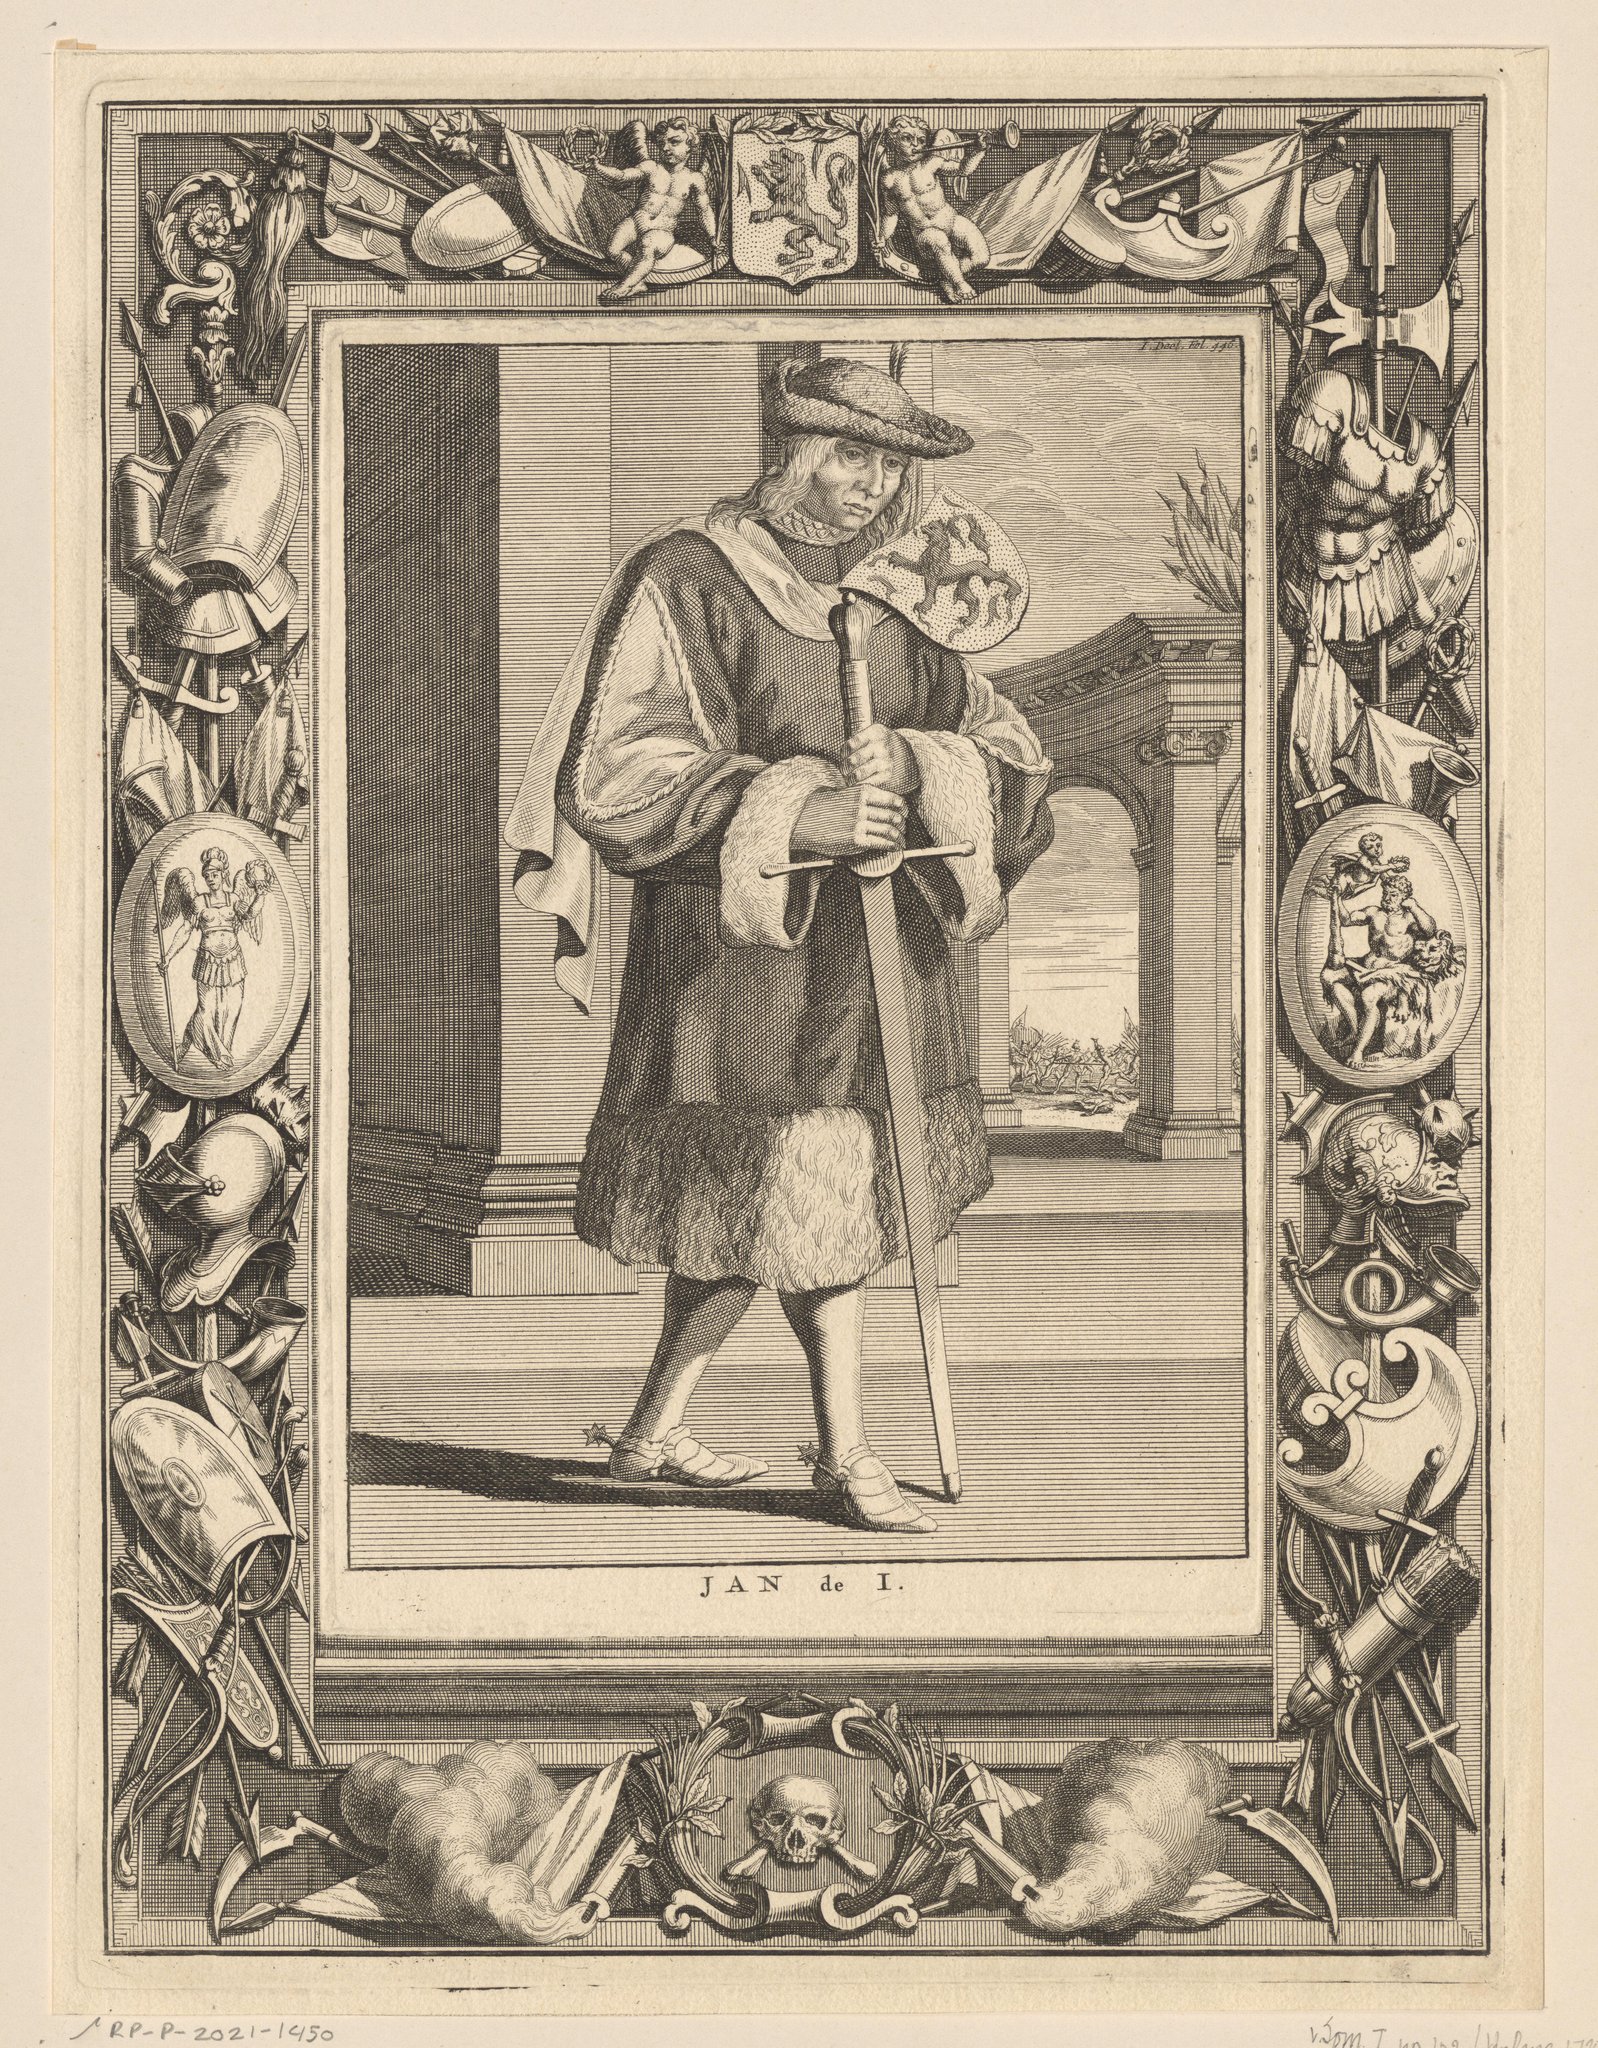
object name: print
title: Portret van Jan I, graaf van Holland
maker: Anonymous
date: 1725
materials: paper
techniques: etching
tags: earl, jan i (graaf van holland), historical persons, weapons, ruler, sovereign, armorial bearing, heraldry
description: Prent waarschijnlijk uit: Halma, François. Tooneel der Vereenigde Nederlanden, en onderhorige landschappen (...). 2 dln. Leeuwarden: Hendrik Halma, 1725, dl. 1, tussen p. 446-447. Eerdere staat van prent gebruikt in: Stoke, Melis. Hollandse jaar-boeken of rijm-kronijk van Melis Stoke. Behelsende de geschiedenissen des lands (...). Leiden: Johannes du Vivié en Isaak Severinus, 1699.